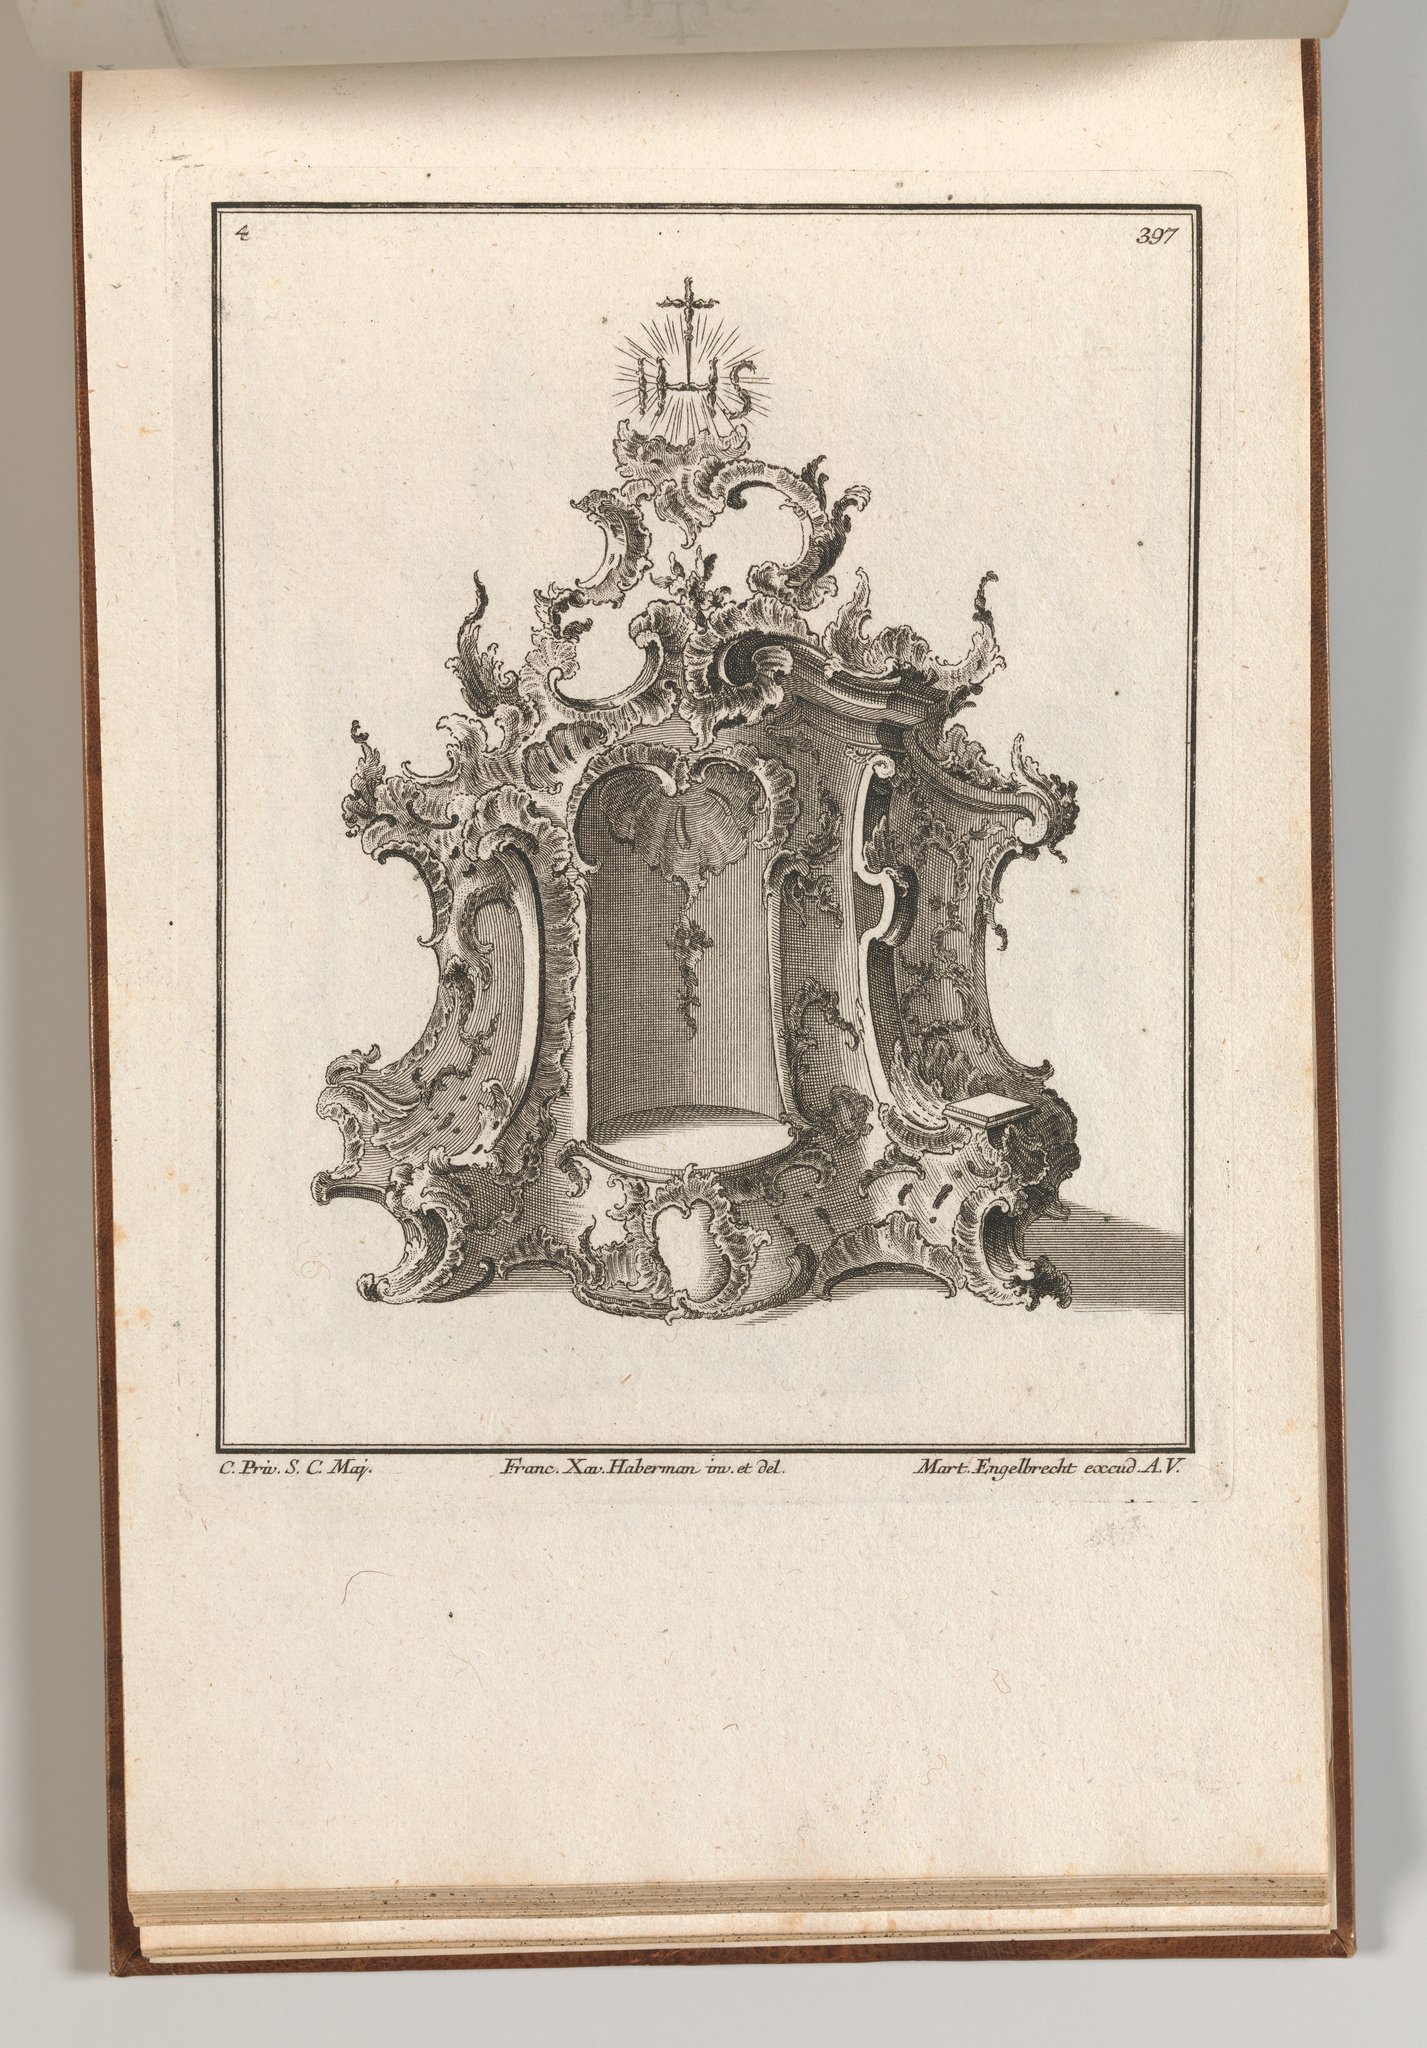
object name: album print ornament architecture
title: Design for a Tabernacle, Plate 4 from the series 'Tabernacle'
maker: franz xavier habermann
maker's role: artist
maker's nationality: german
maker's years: 1721-1796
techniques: etching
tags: tabernacles